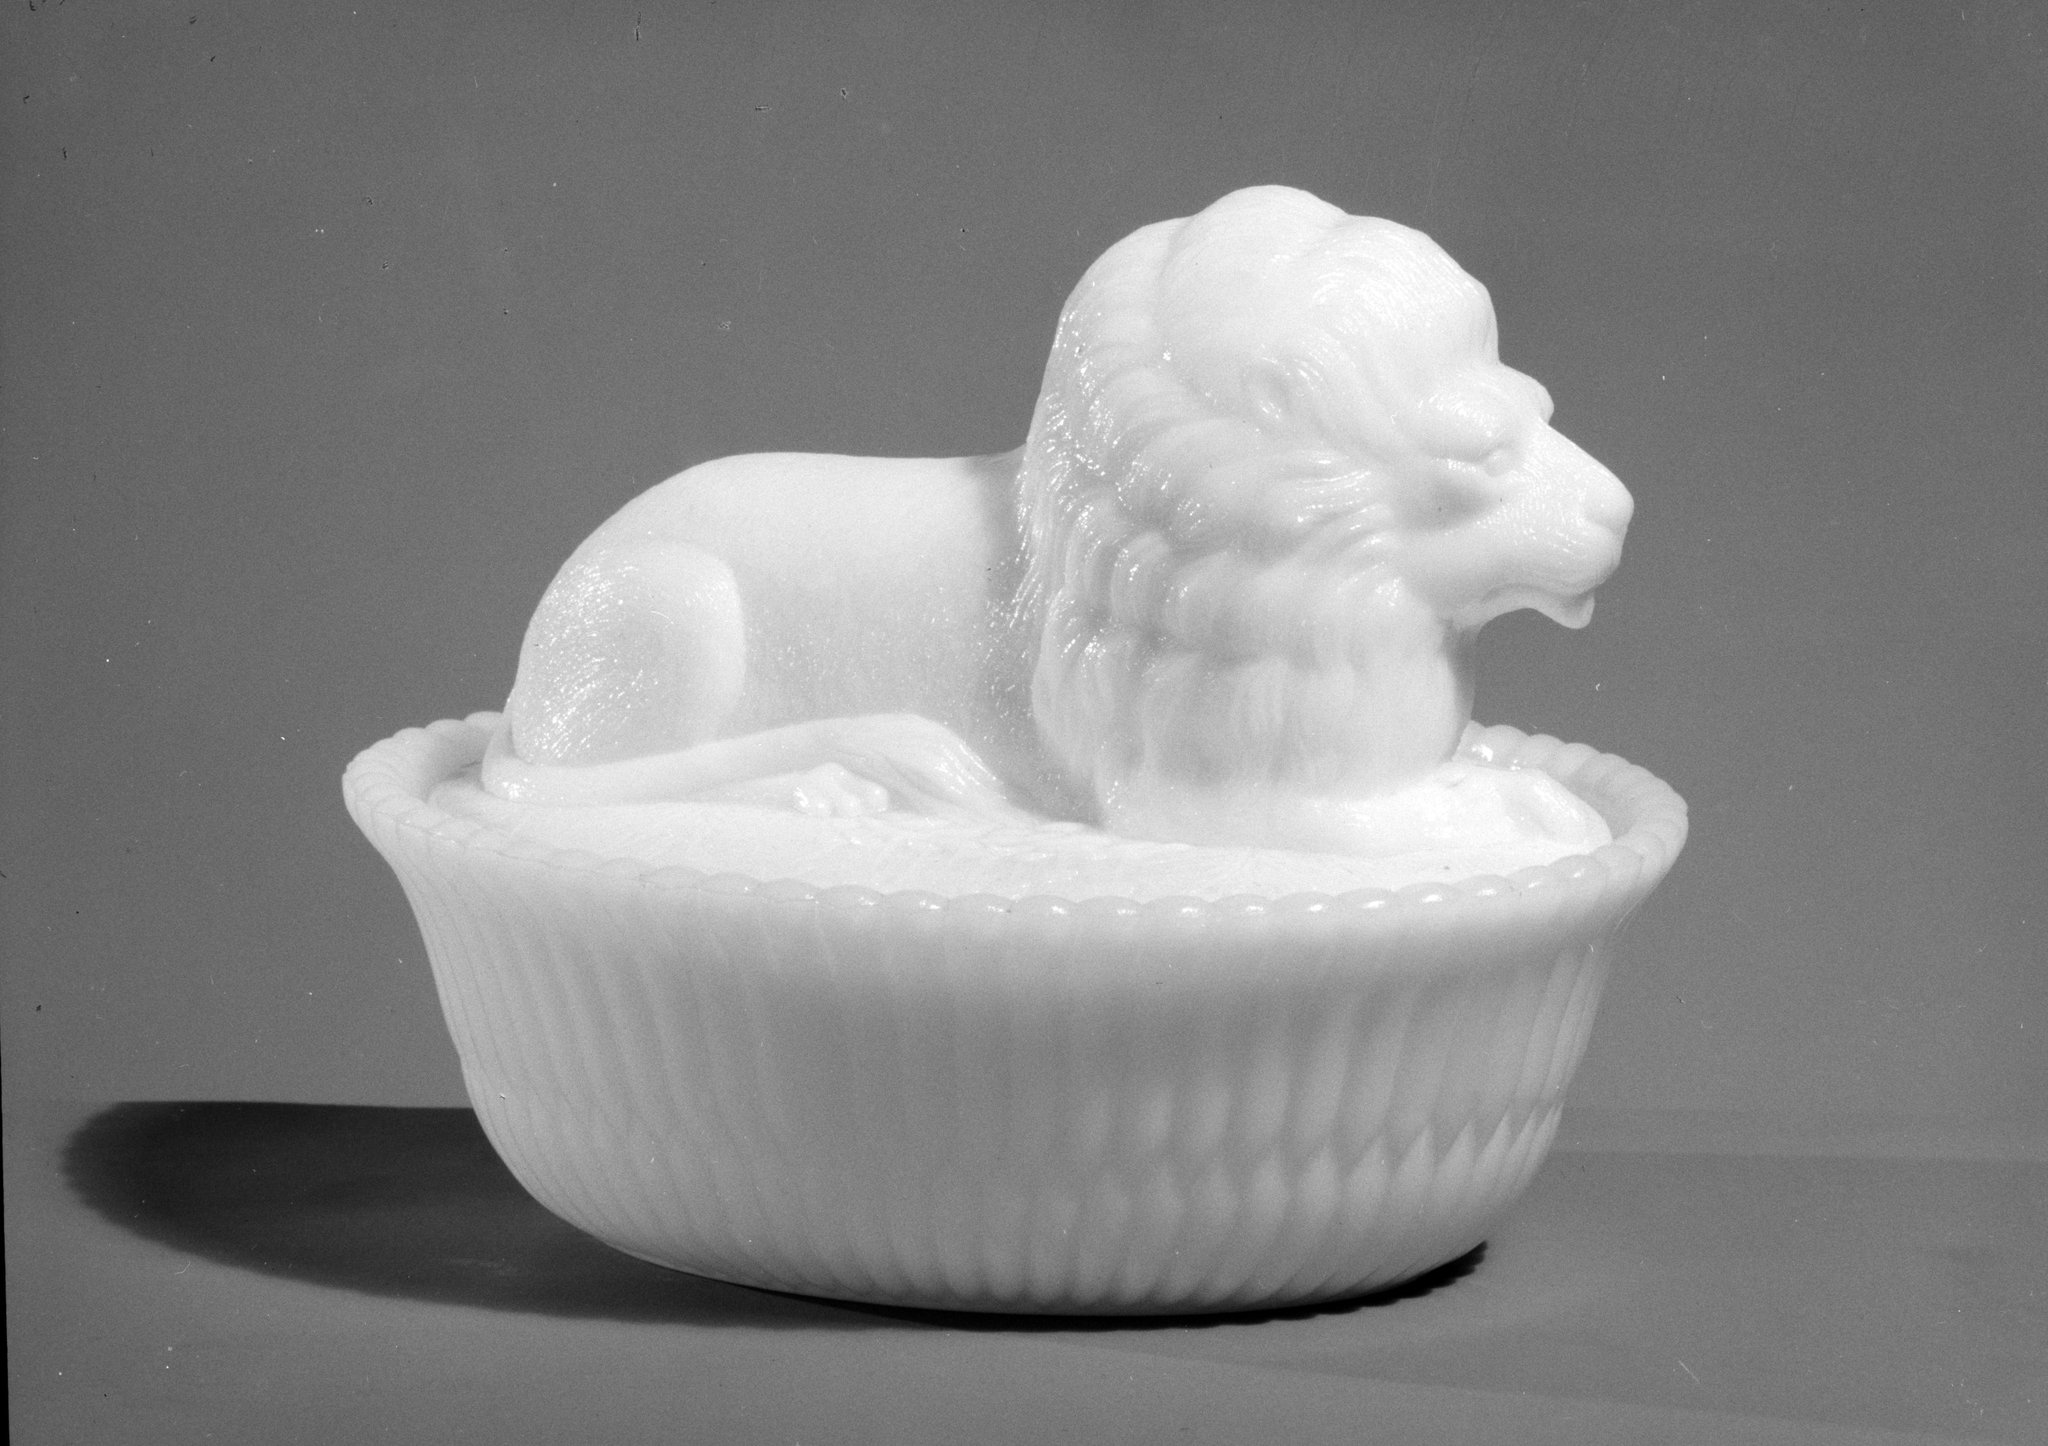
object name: dish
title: Figure Dish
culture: american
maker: mckee and brothers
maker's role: maker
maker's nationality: american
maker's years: 1856-1889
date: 1880-1890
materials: glass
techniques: pressed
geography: united states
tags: lions